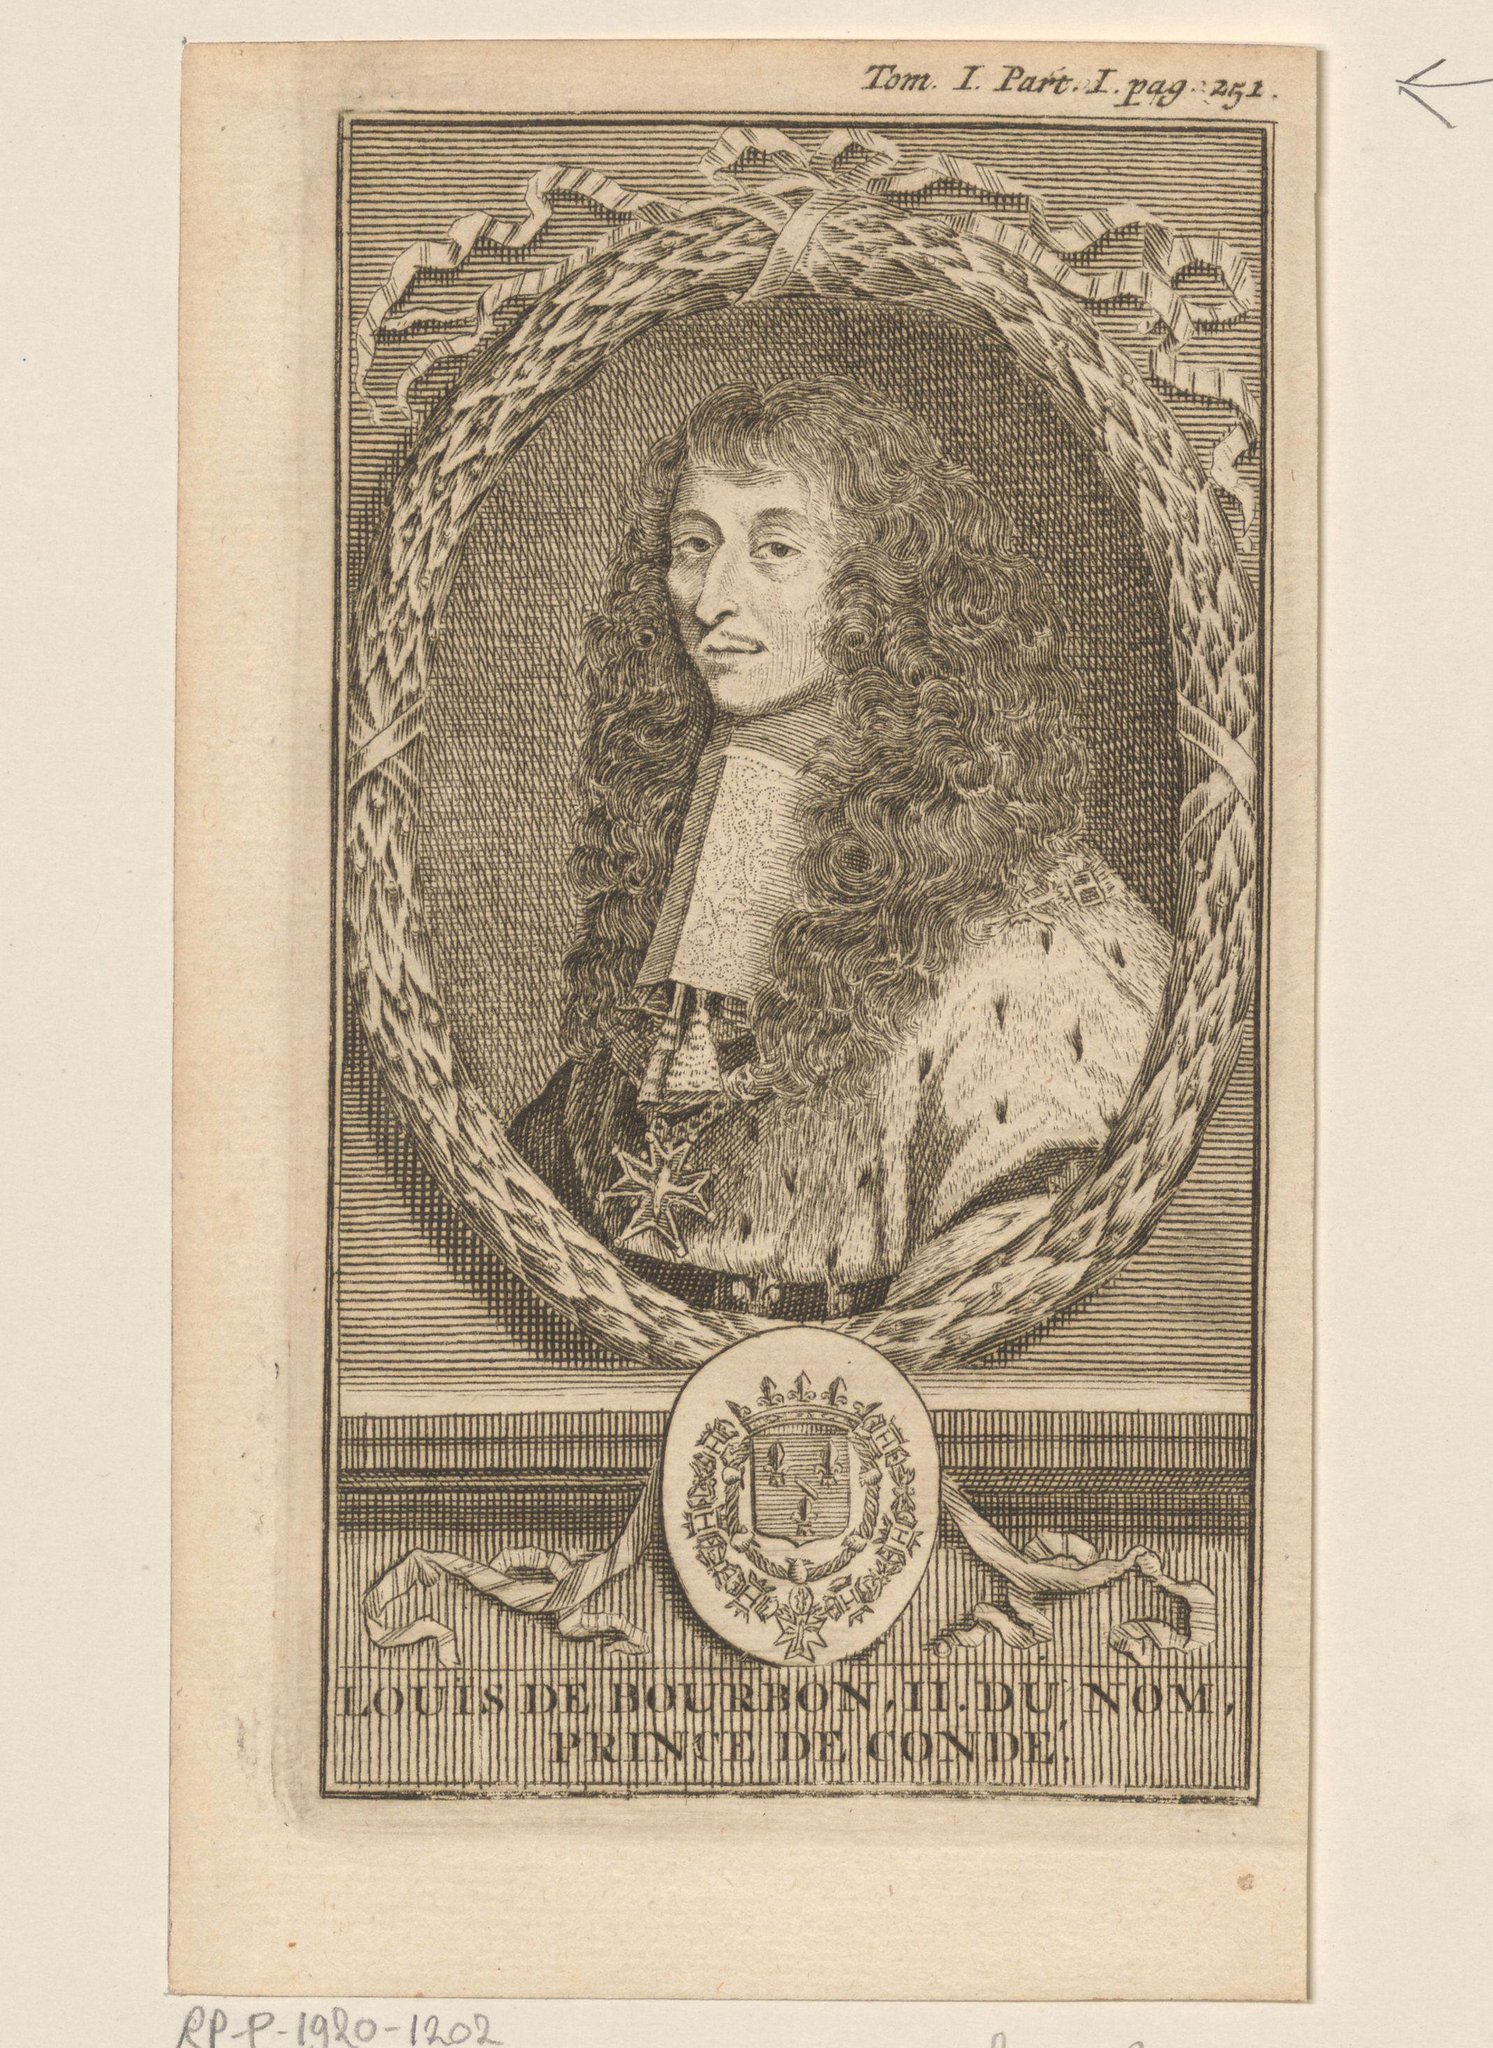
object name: print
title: Portret van Lodewijk II de Bourbon-Condé, hertog van Enghien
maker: Anonymous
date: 1650-1749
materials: paper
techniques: engraving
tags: lodewijk ii de bourbon-condé (hertog van enghien), historical persons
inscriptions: collector's mark: Lugt 2228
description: Rechtsboven genummerd: Tom. I. Part. I pag. 251.